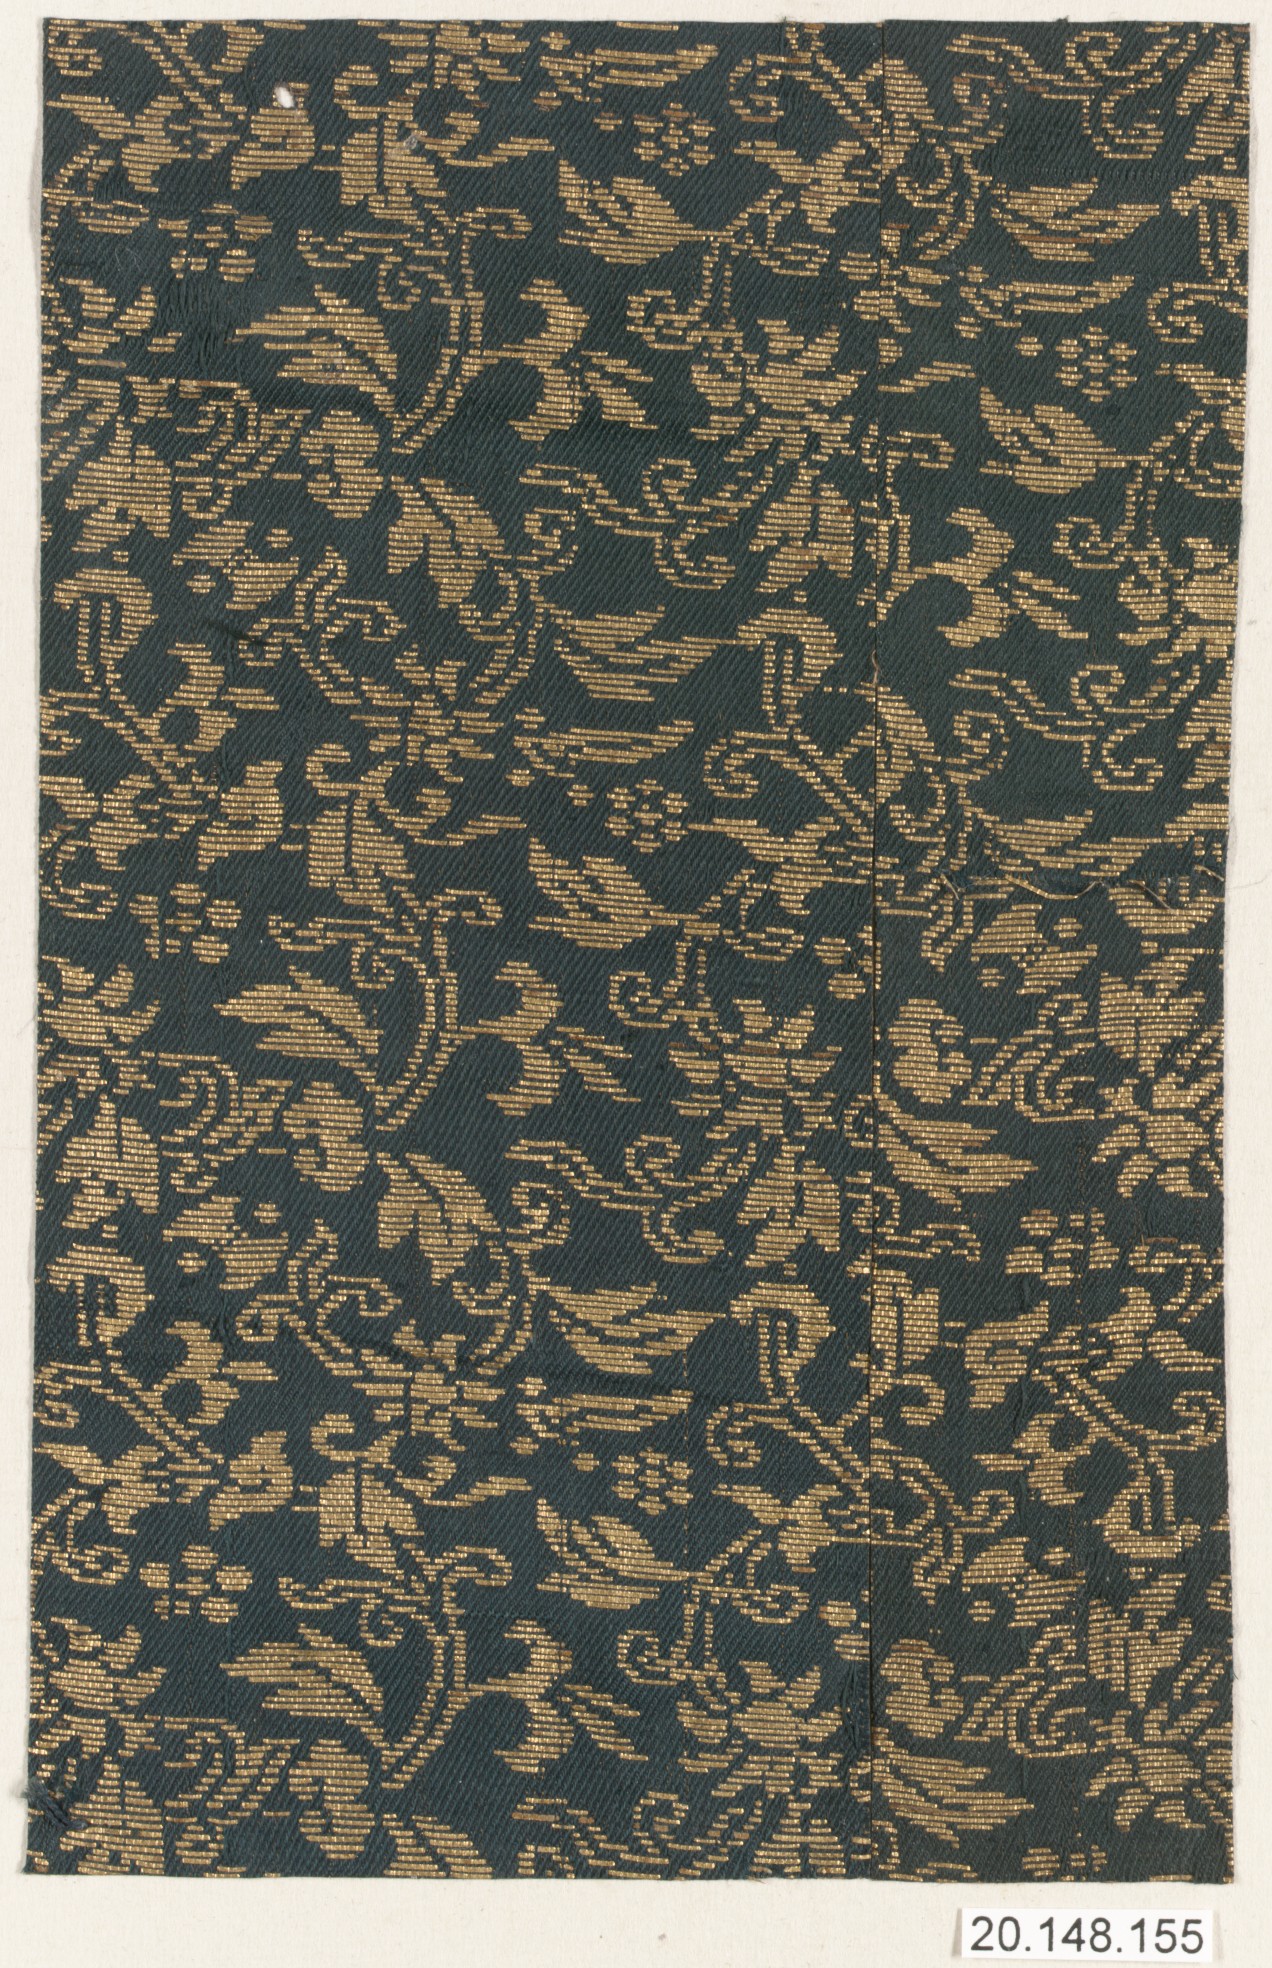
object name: piece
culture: japanese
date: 1601-1700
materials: silk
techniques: compound weave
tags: leaves